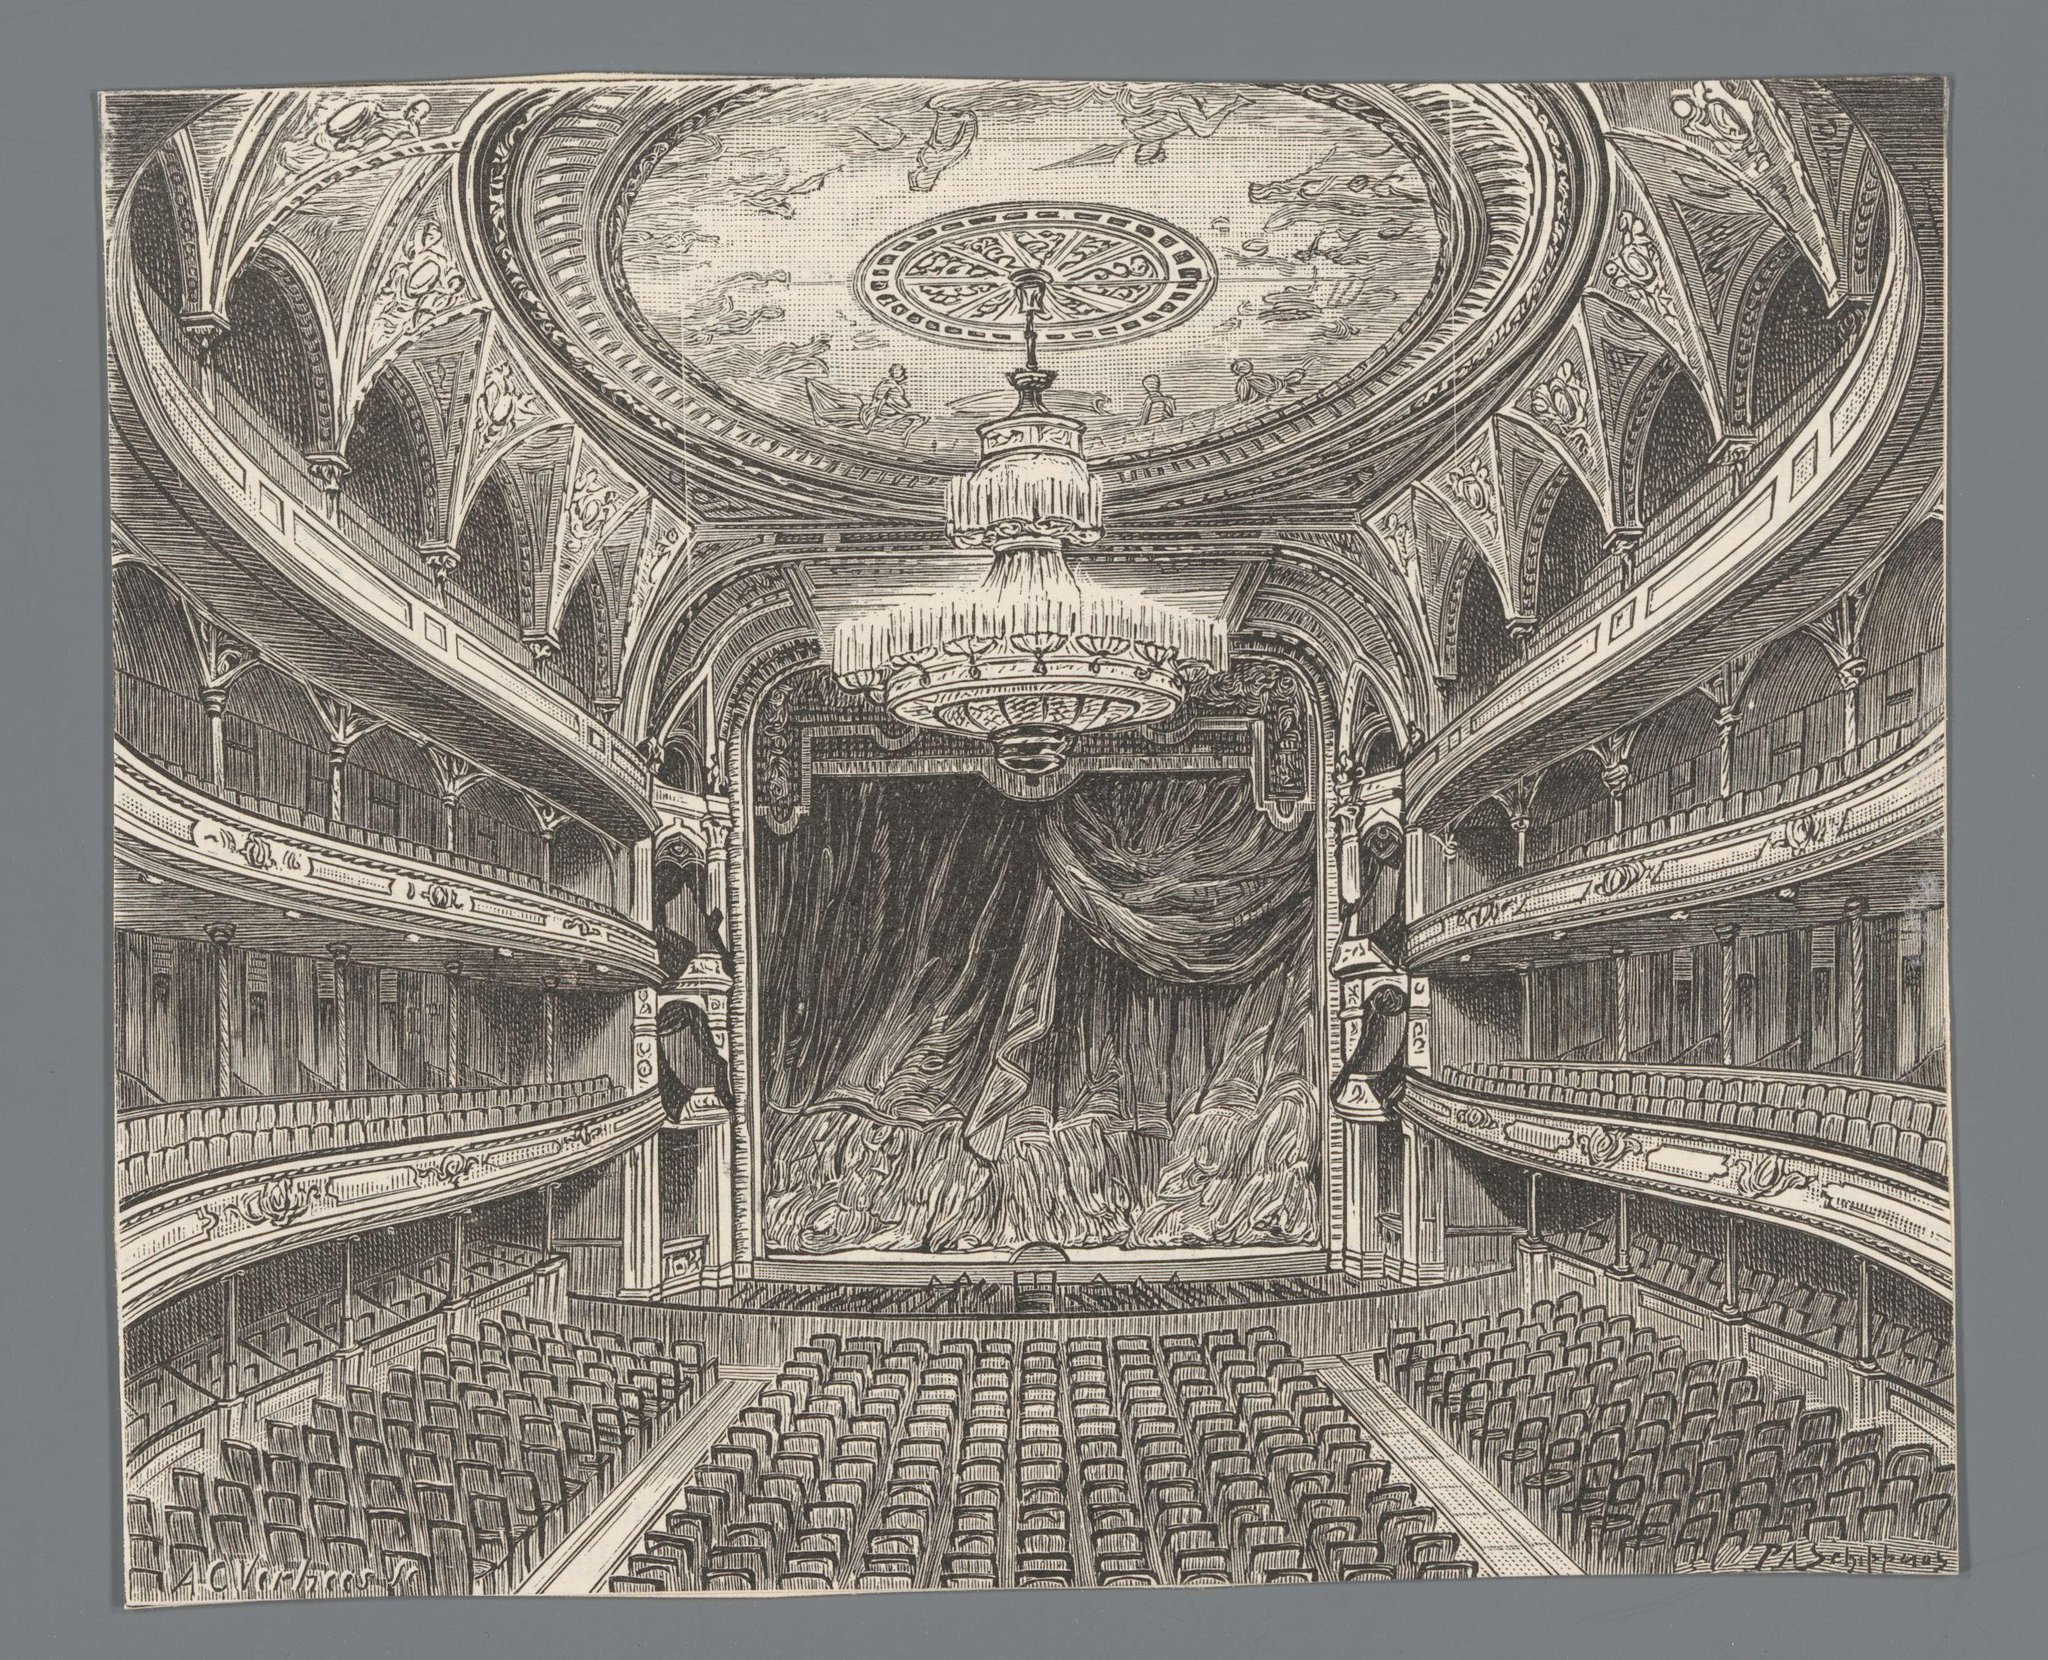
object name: print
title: Interieur van een schouwburgzaal, gezien vanaf het achterbalkon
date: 1850-1900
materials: paper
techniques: engraving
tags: theatre (building), the stage and its equipment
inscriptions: collector's mark: Lugt 2228